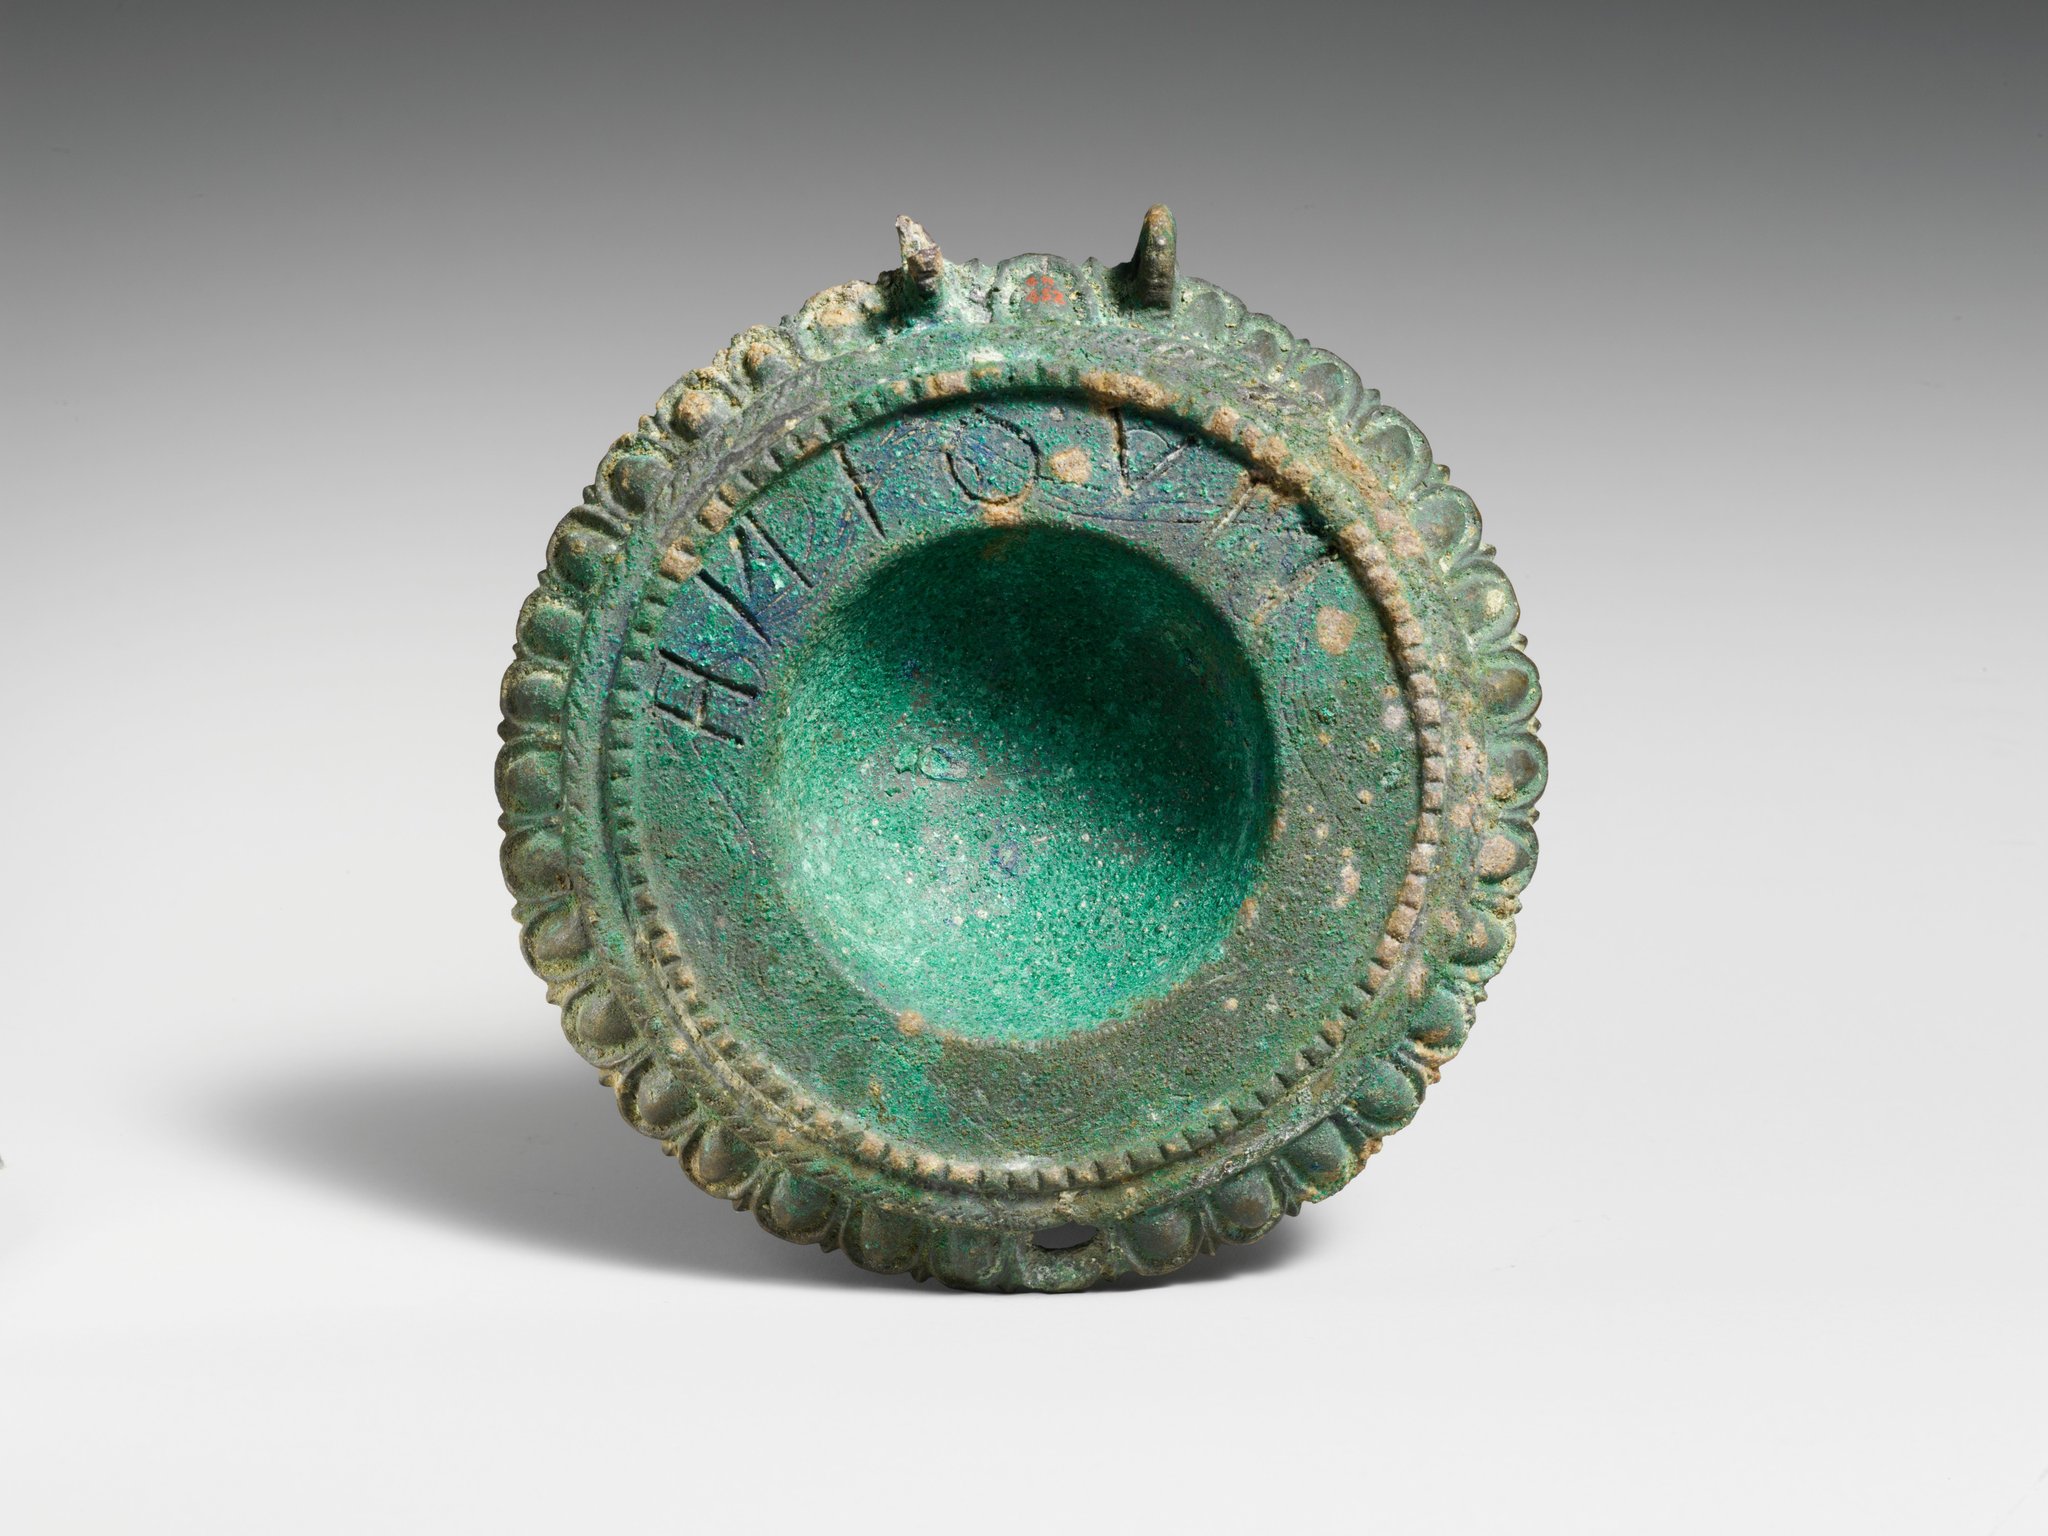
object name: thymiaterion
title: Bronze bowl from a thymiaterion (incense burner)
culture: etruscan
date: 334-301 BCE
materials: bronze